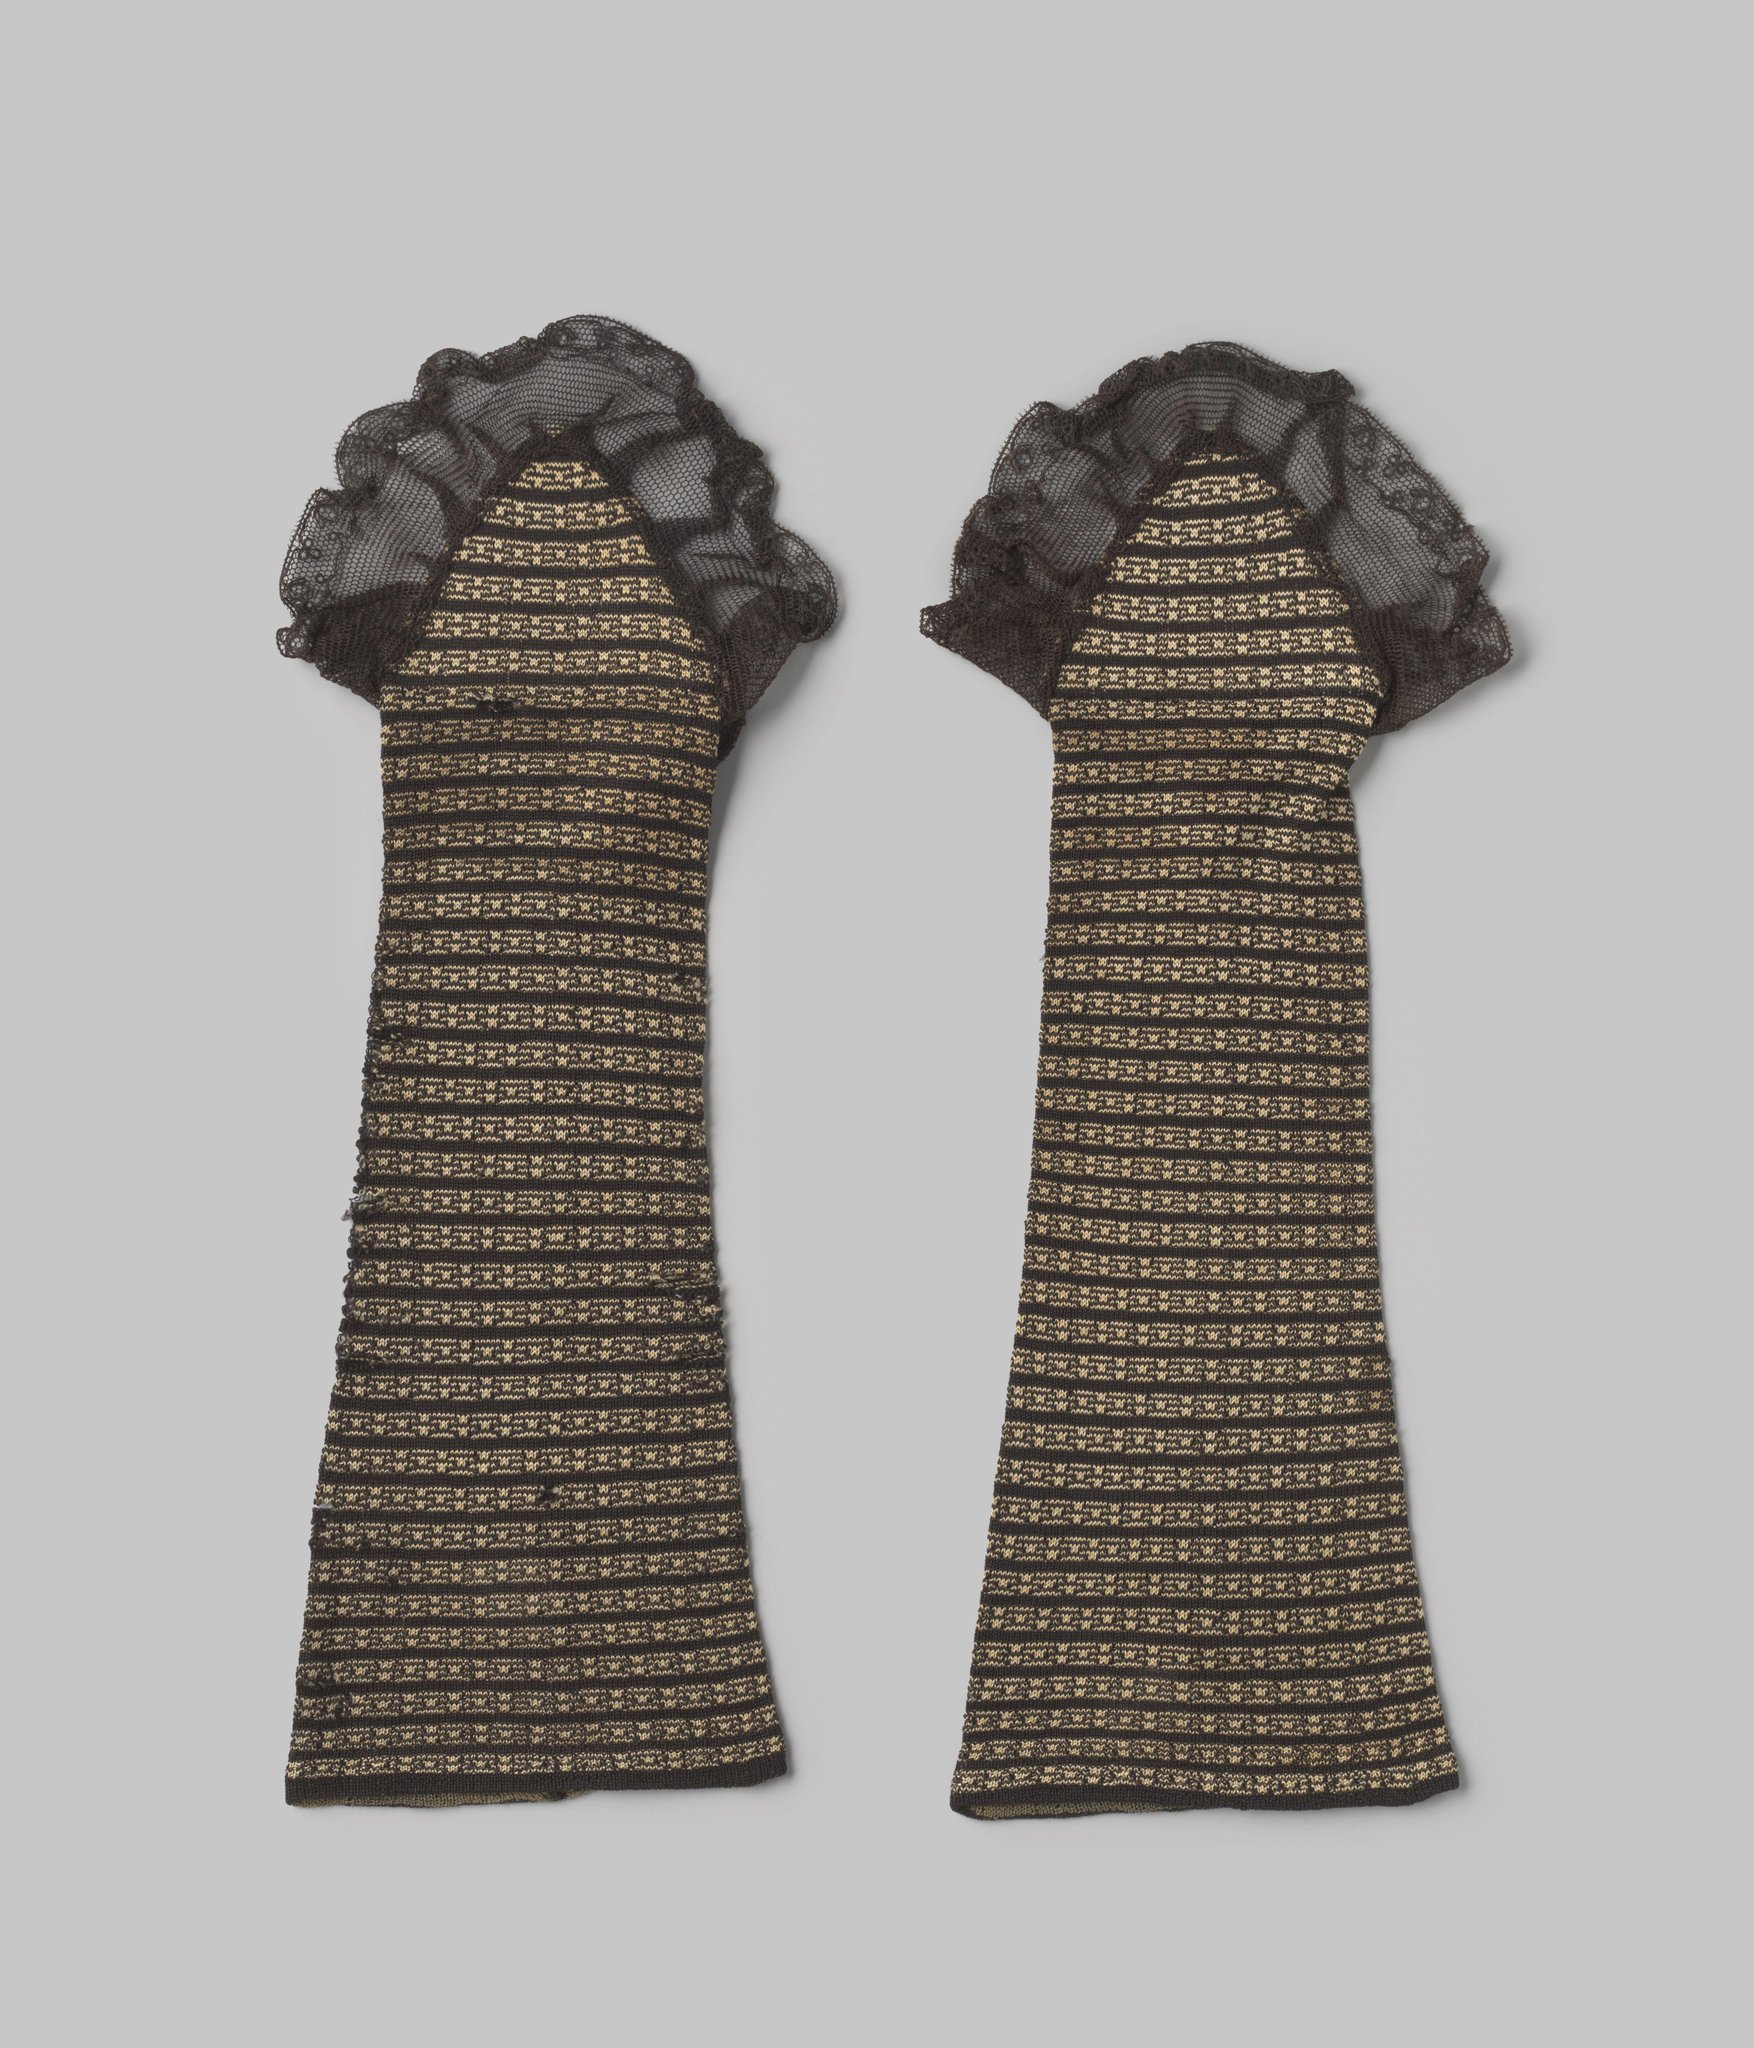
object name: mitt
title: Mitaine van zijde, wit en zwartgestreept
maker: Anonymous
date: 1750-1800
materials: silk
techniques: knitting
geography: zaanstreek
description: Mitaine van zijde, wit en zwart gestreept. In de witte banen met een zwart omlijnd geometrisch patroon. Afgezet met zwarte doorstop tule.